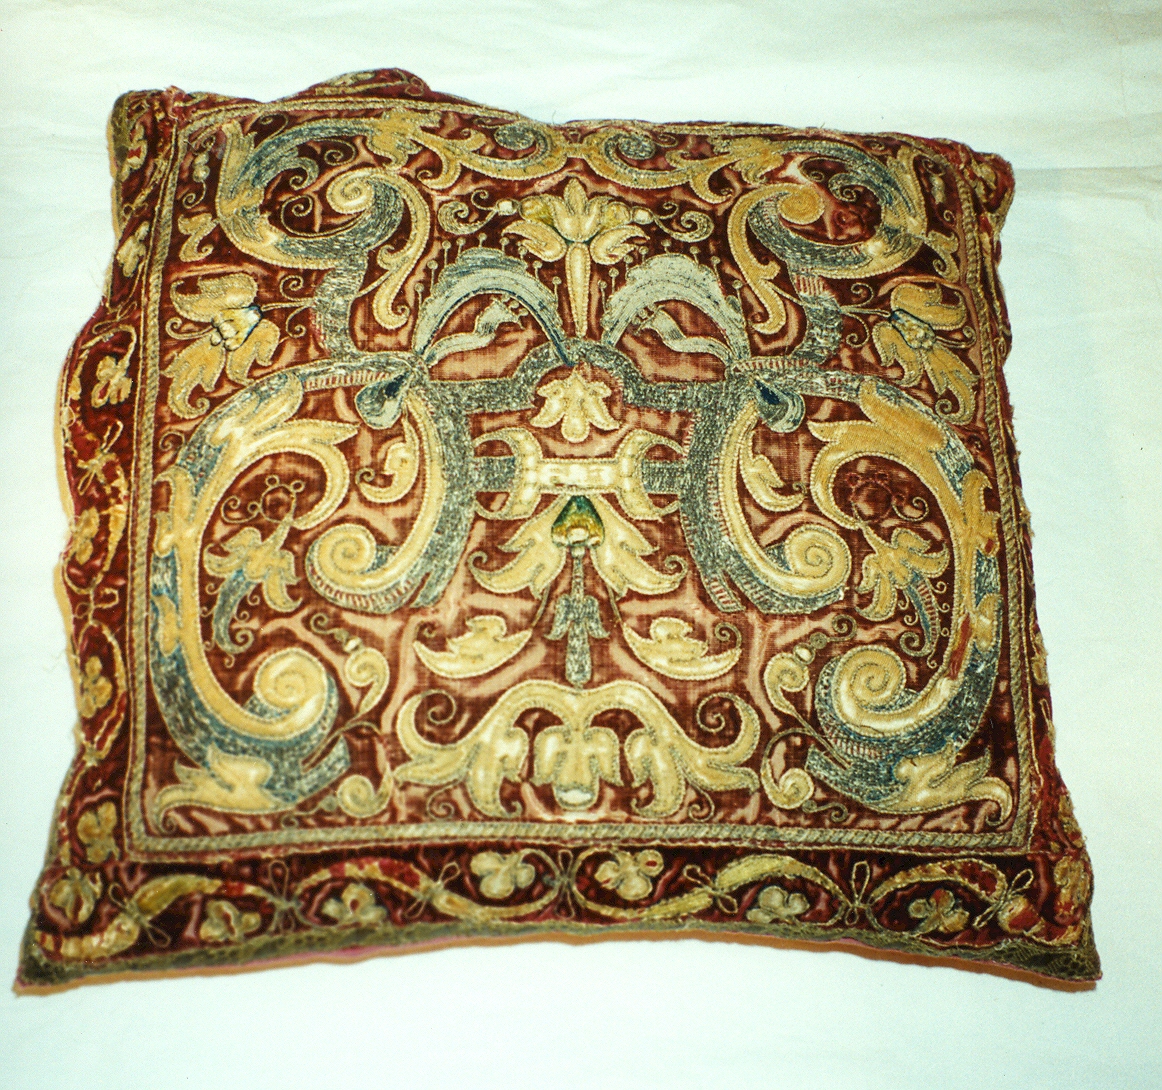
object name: clothing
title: Apparel made into a cushion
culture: italian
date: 1601-1700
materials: metal, silk